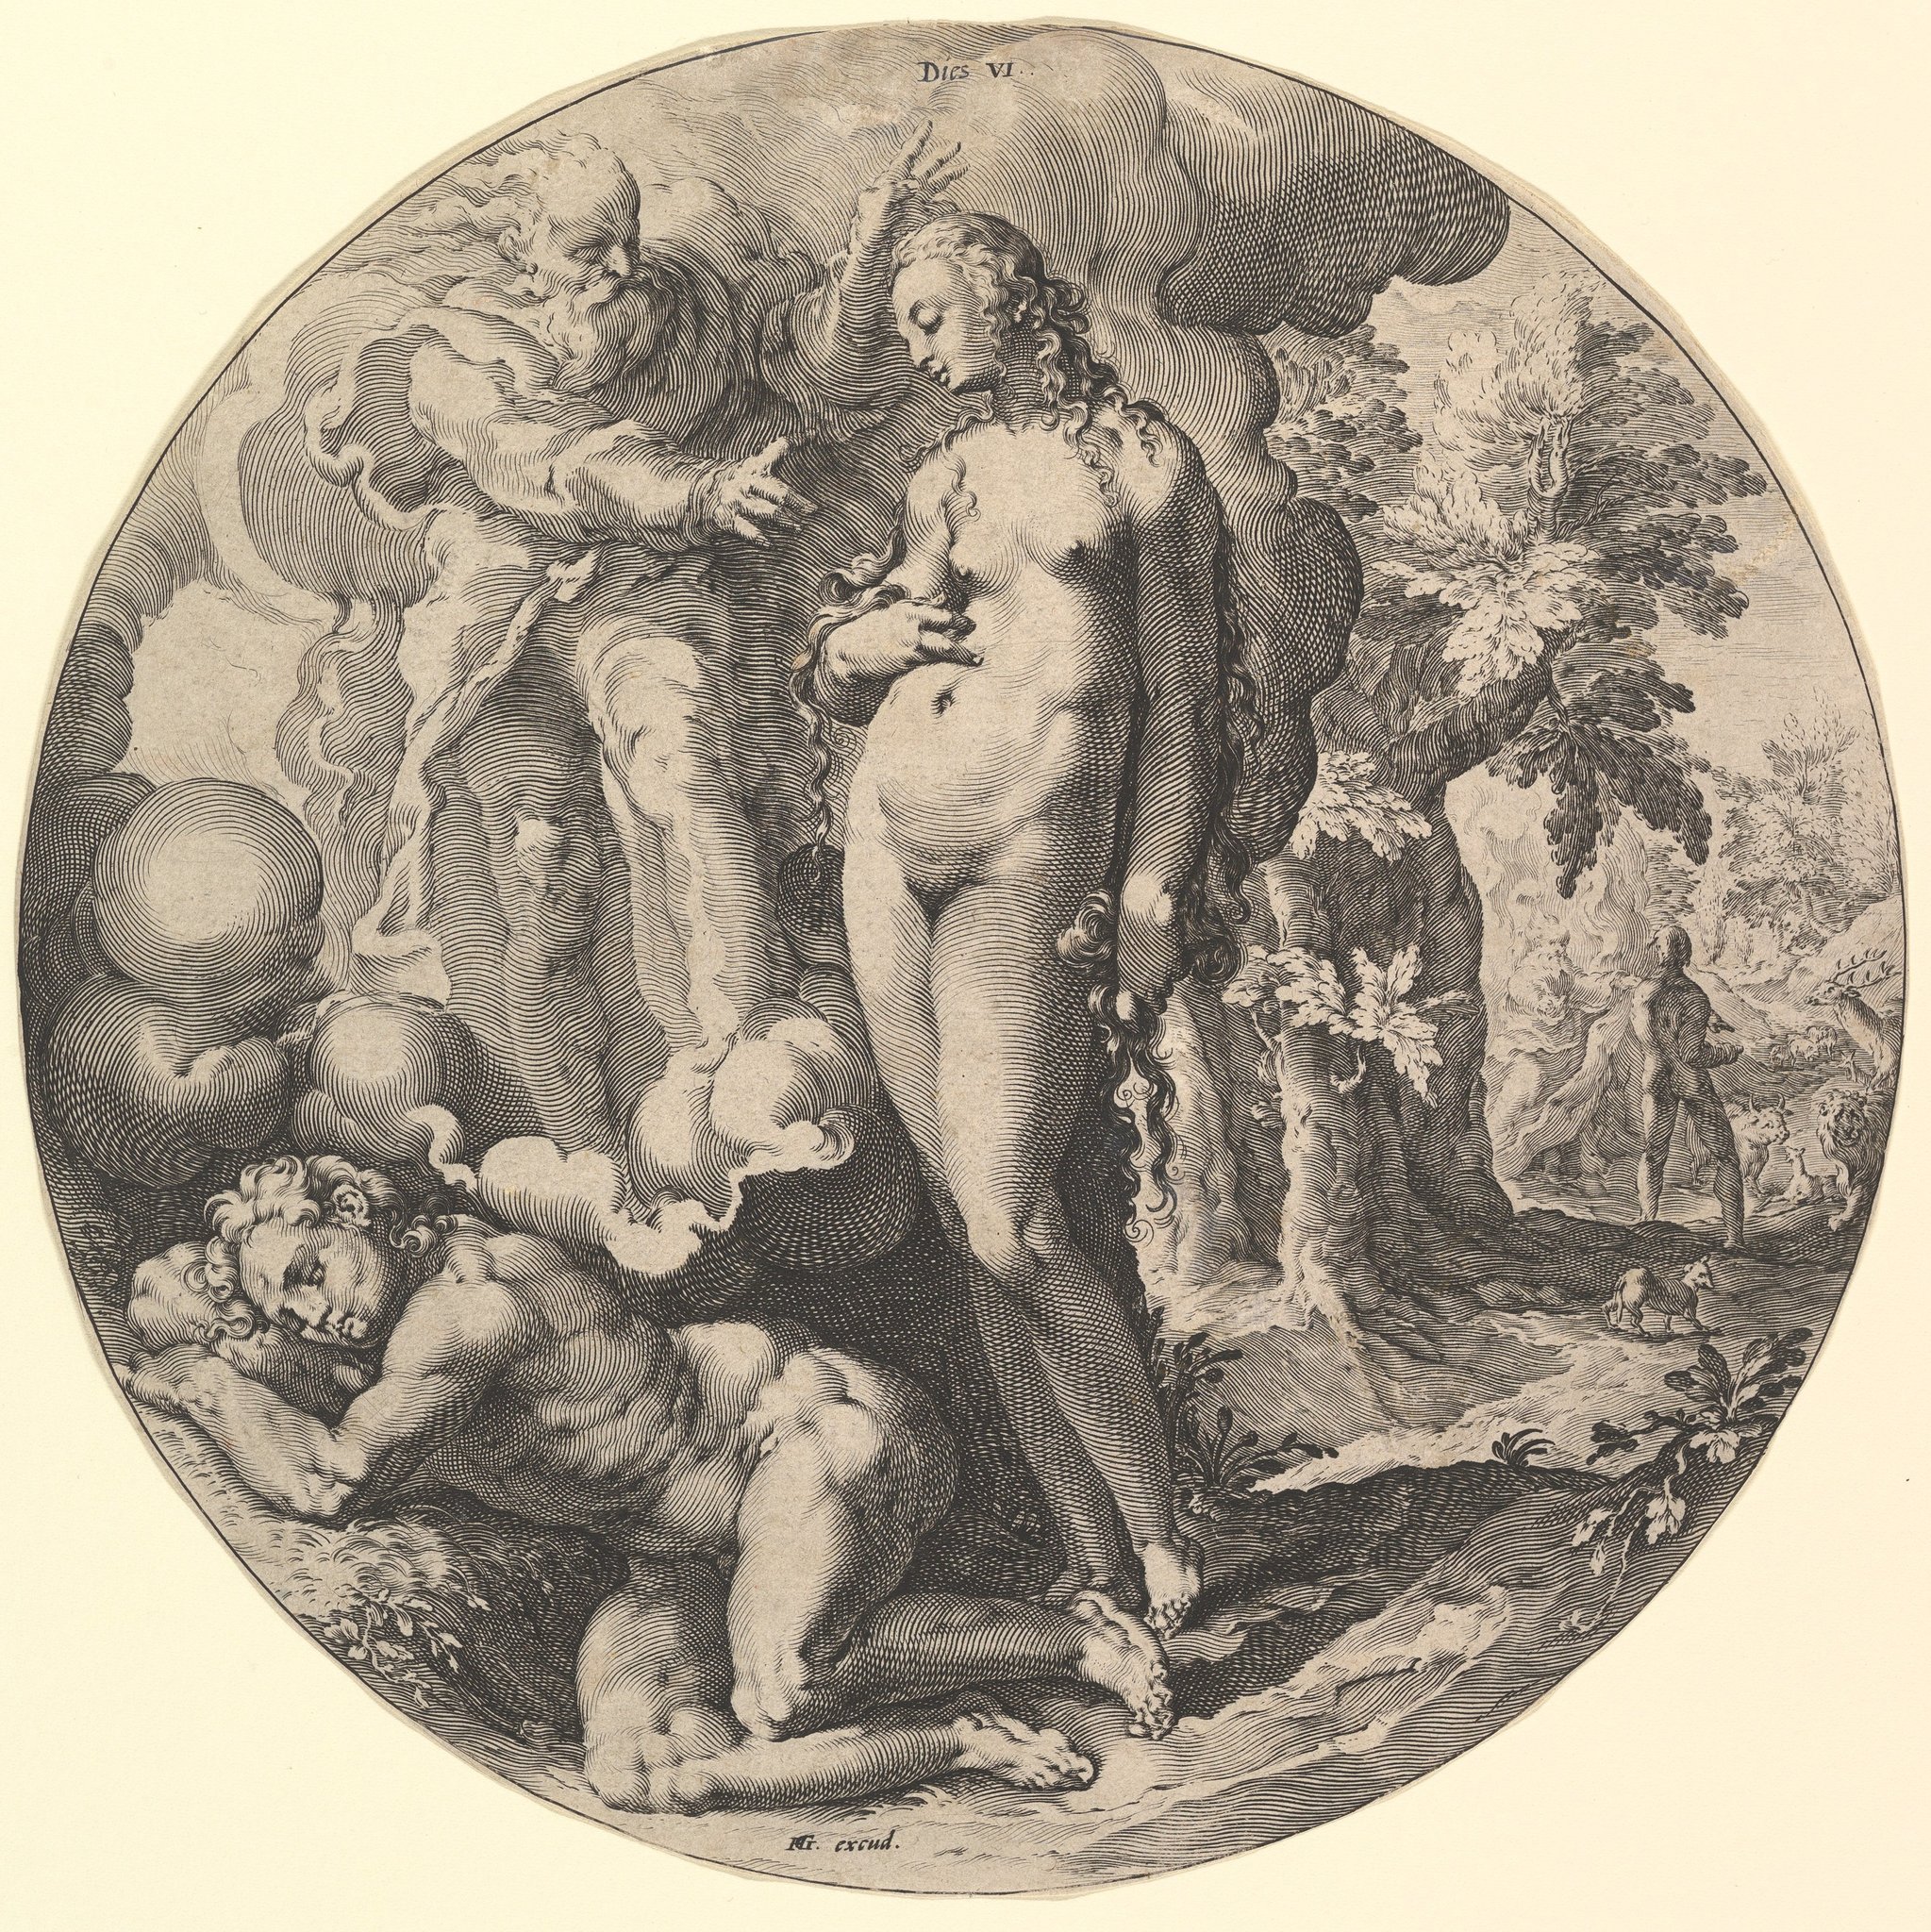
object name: print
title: The Sixth Day (Dies VI): The Creation of Adam and Eve, from "The Creation of the World"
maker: jan muller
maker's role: artist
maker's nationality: netherlandish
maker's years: 1571-1628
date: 1589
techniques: engraving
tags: adam,eve